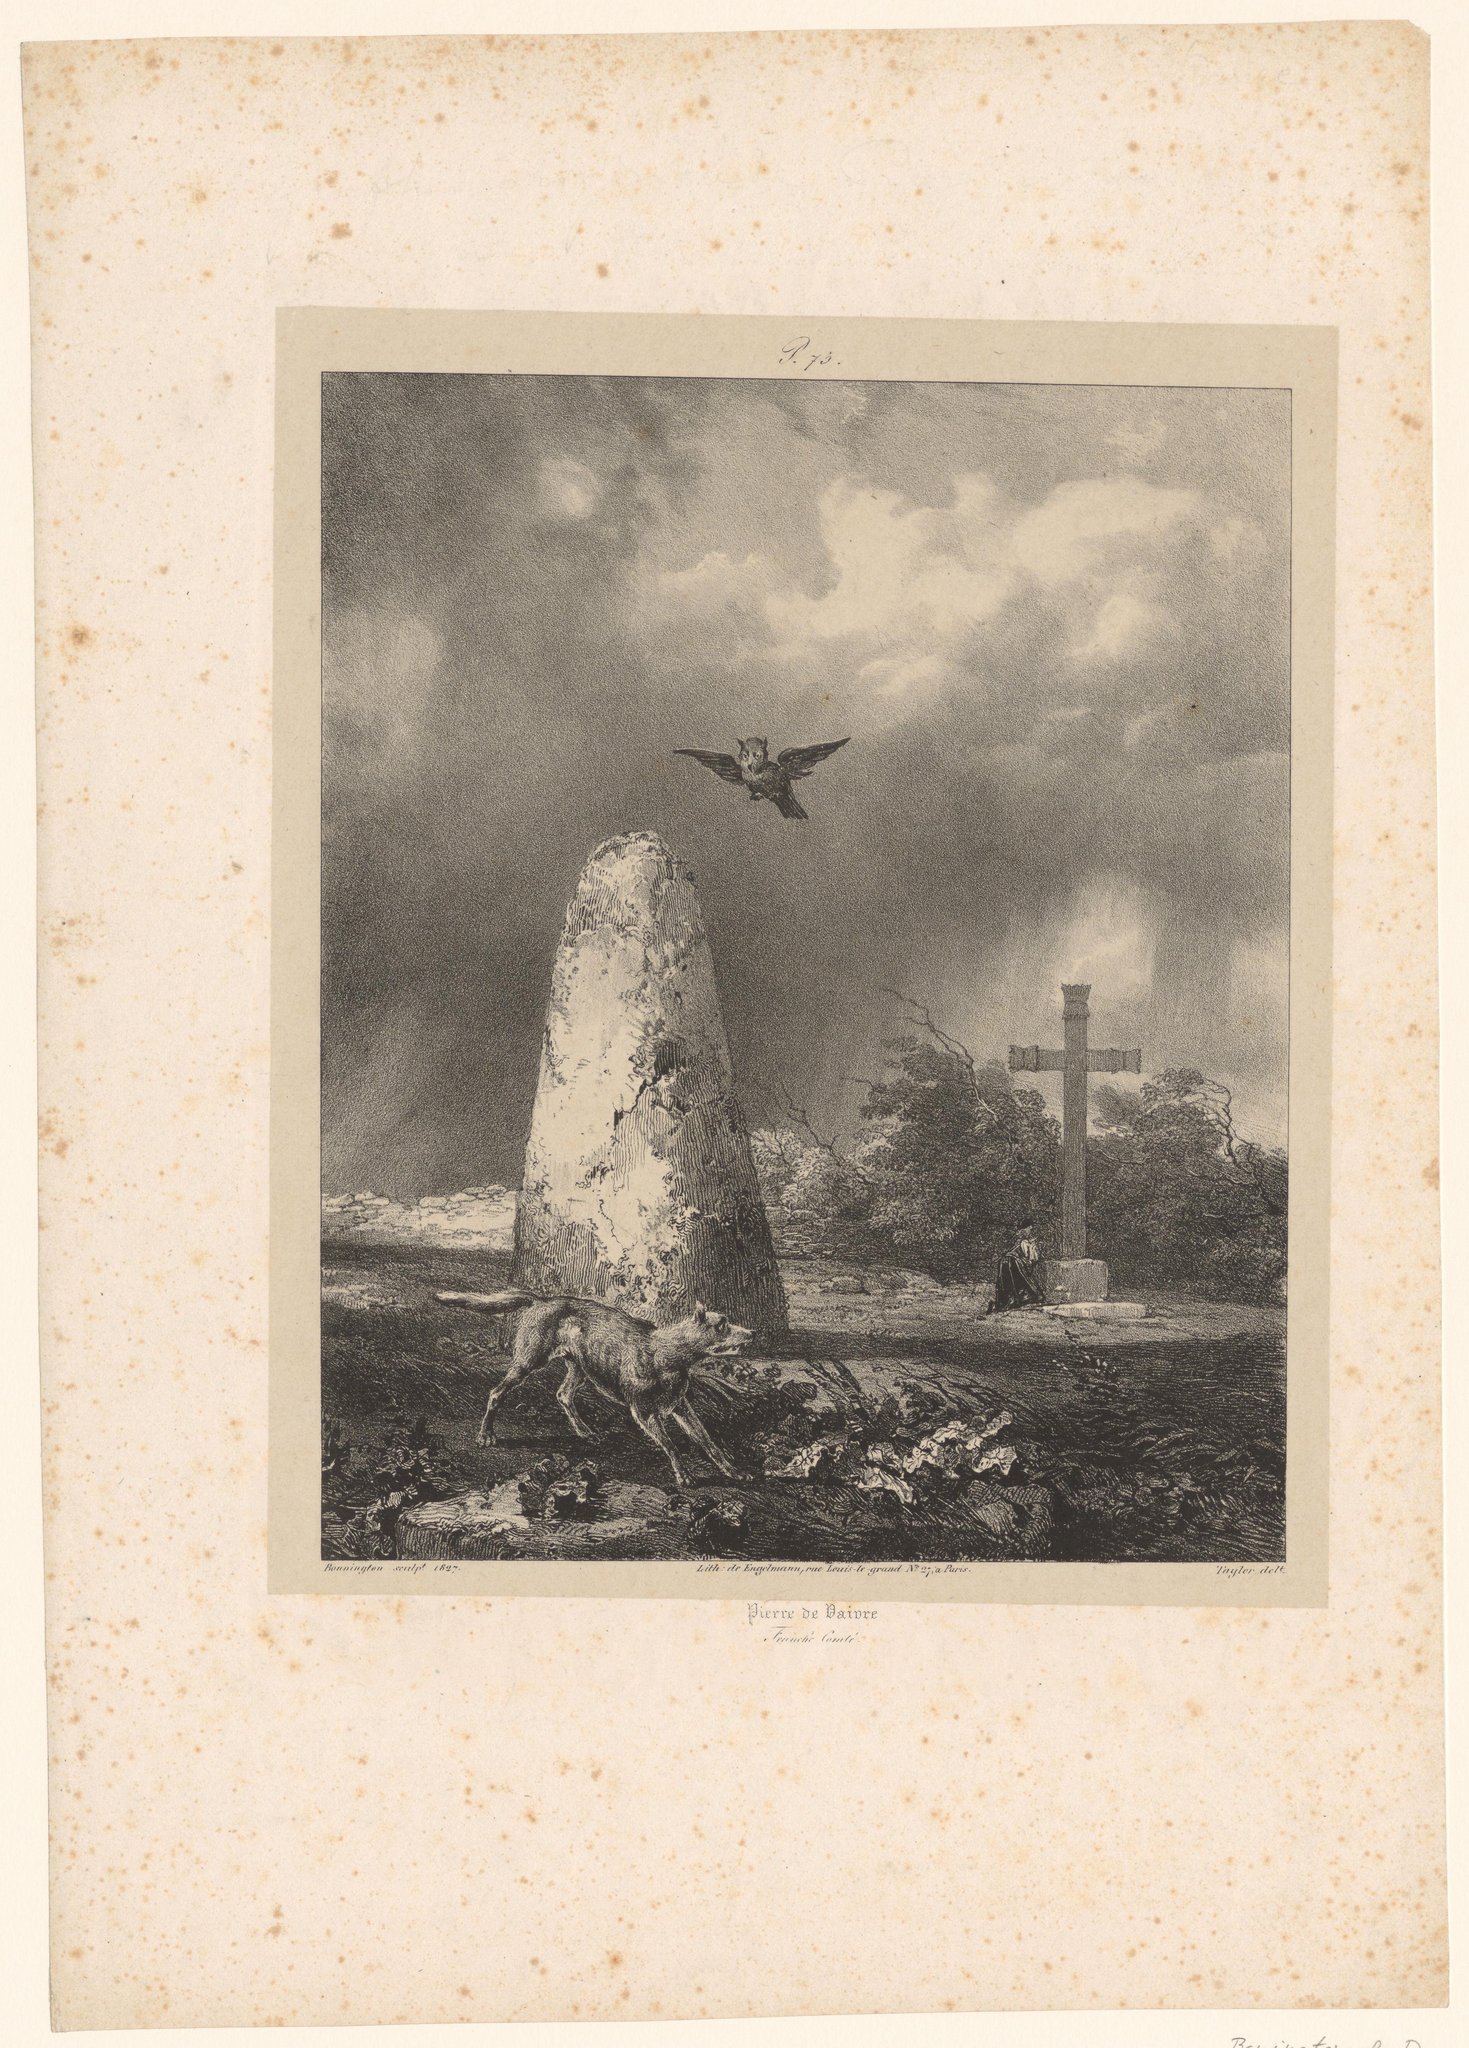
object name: print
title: Gezichten op het oude Frankrijk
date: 1827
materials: paper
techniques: lithograph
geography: paris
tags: owls, rock-formations, other kinds of grave-markers, e.g. cross, dog, france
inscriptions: collector's mark: Lugt 2760, collector's mark: Lugt 2166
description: Deze prent behoort tot de serie 'Voyages pittoresques et romantiques dans l'ancienne France'. De serie is uitgevoerd onder leiding van Isidore Justin Séverin baron Taylor en bevat begeleidende teksten van Charles Nodier en Alphonse de Cailleux. Voor het project zijn vele kunstenaars naar delen van Frankrijk afgereisd. De reeks is tussen 1821 en 1878 in ca. 21 delen gepubliceerd.